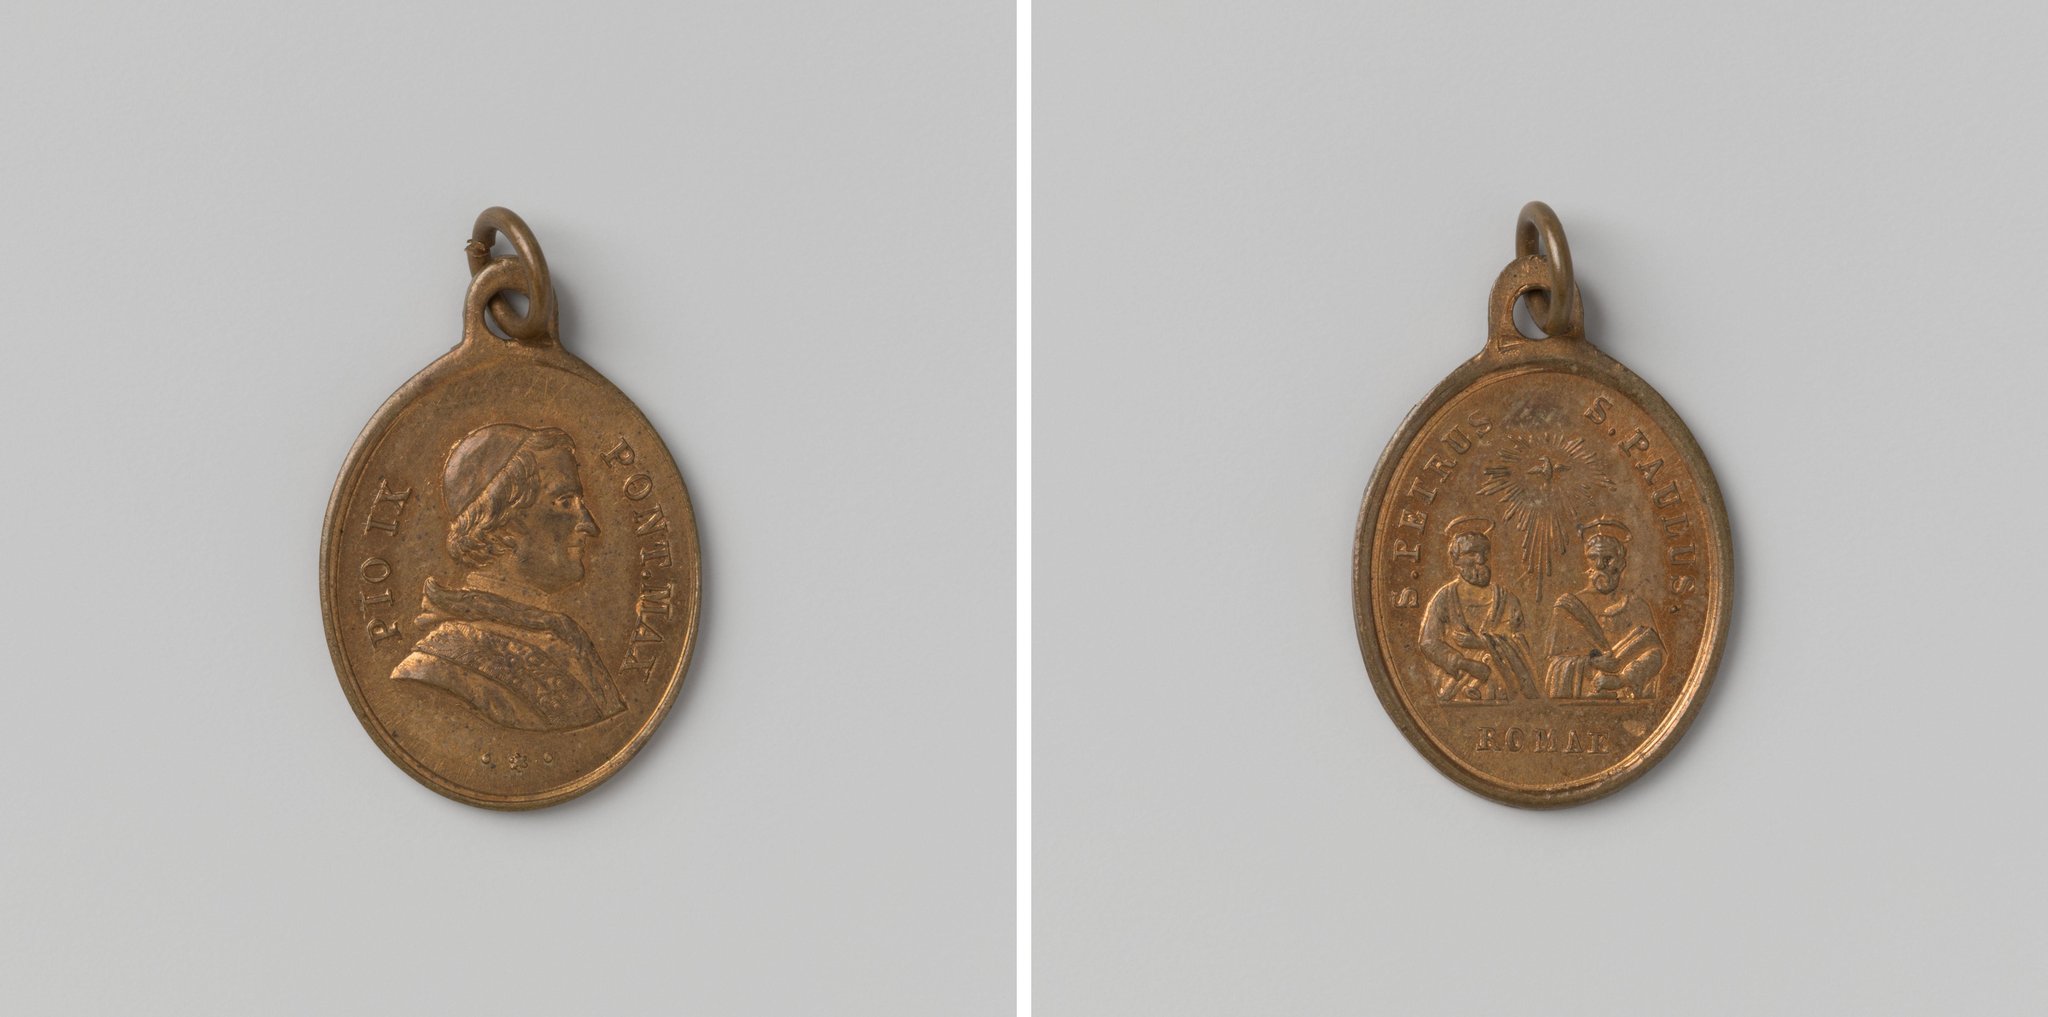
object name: devotional medal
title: Paus Pius IX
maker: Anonymous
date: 1846-1878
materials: brass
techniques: striking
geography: rome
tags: rome